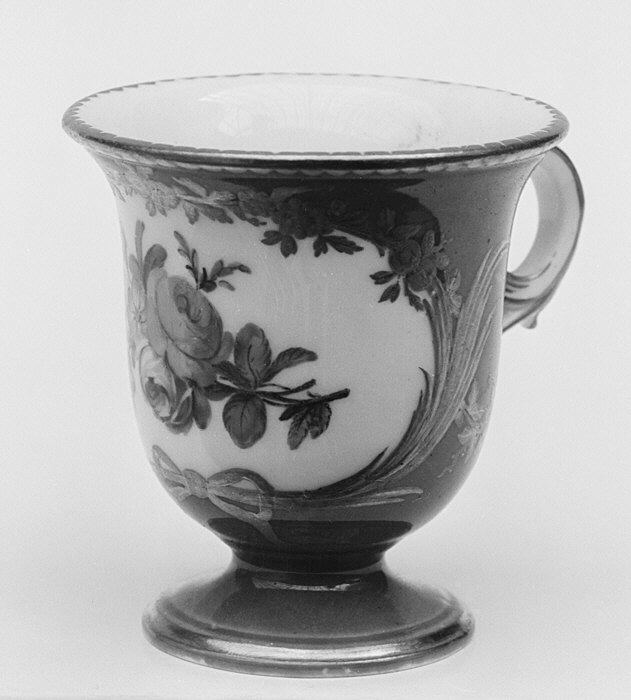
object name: ice cream cup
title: Ice cream cup (tasse à glace) (one of thirty-one) (part of a service)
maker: sèvres manufactory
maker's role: manufactory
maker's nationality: french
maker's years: 1740-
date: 1780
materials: soft paste porcelain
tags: flowers